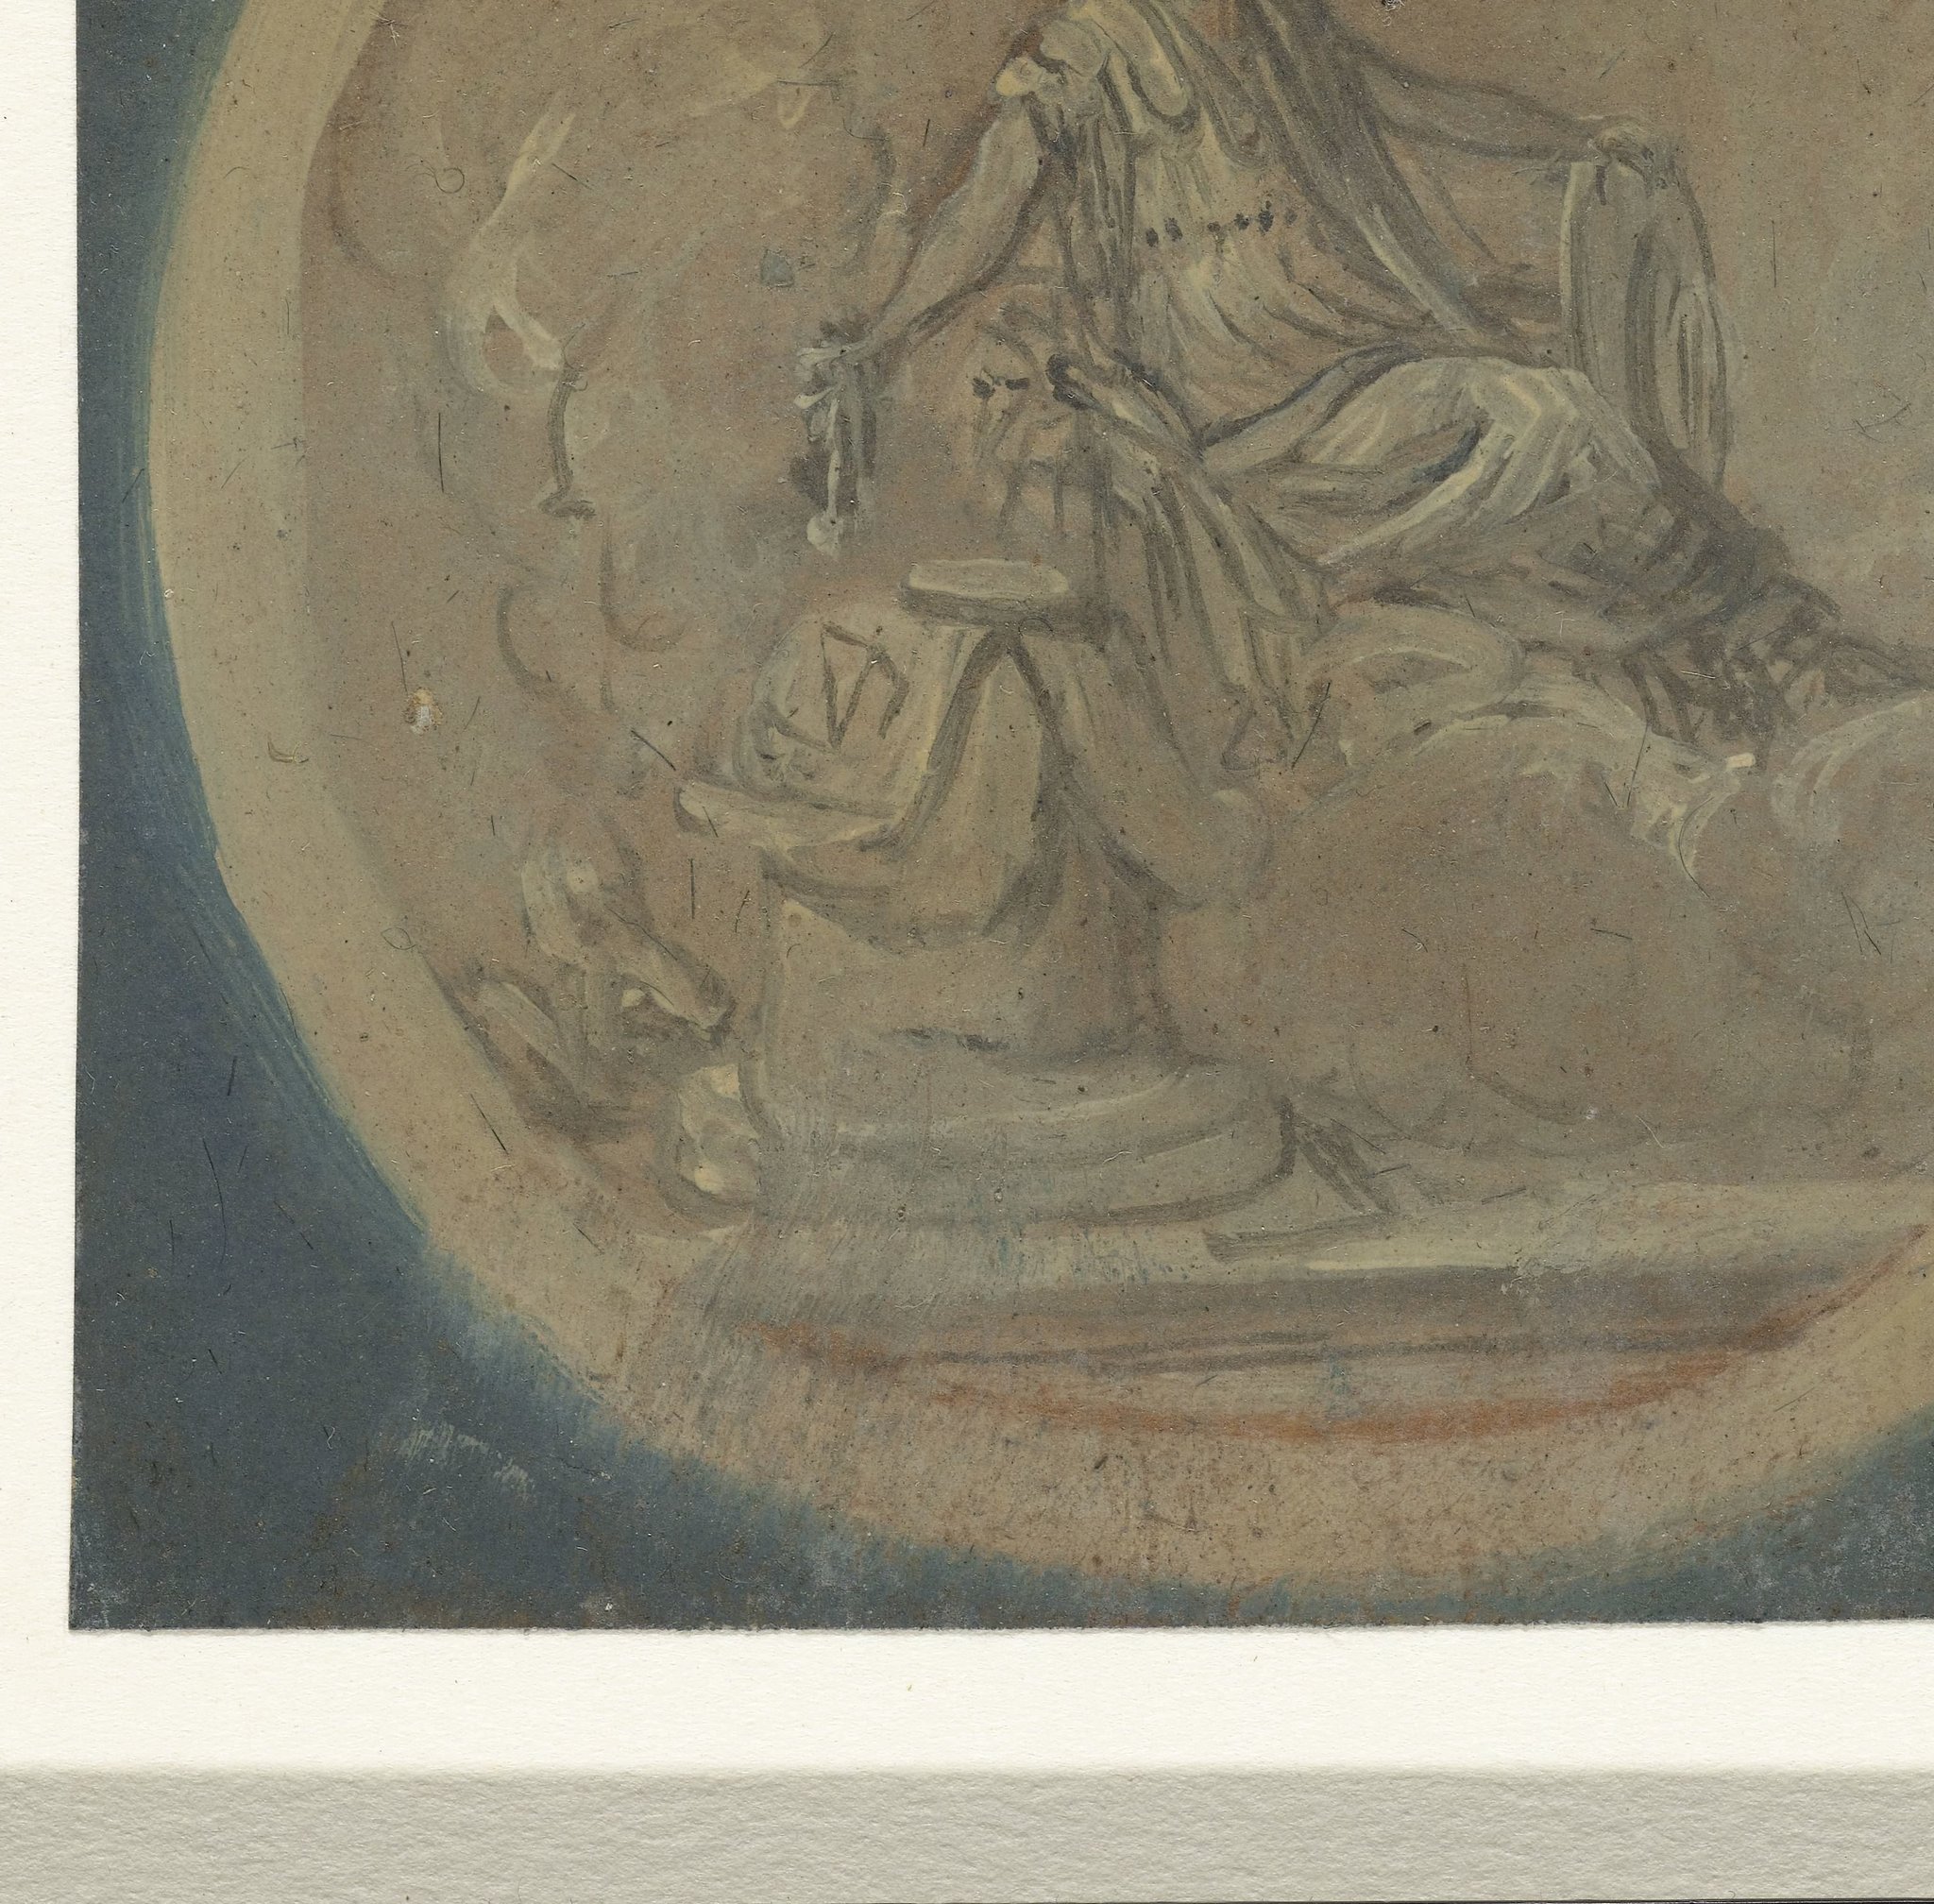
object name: drawing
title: Vignet met Minerva, zittend in de wolken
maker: Anonymous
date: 1700-1800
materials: oil, paper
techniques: brush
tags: minerva as patroness, art